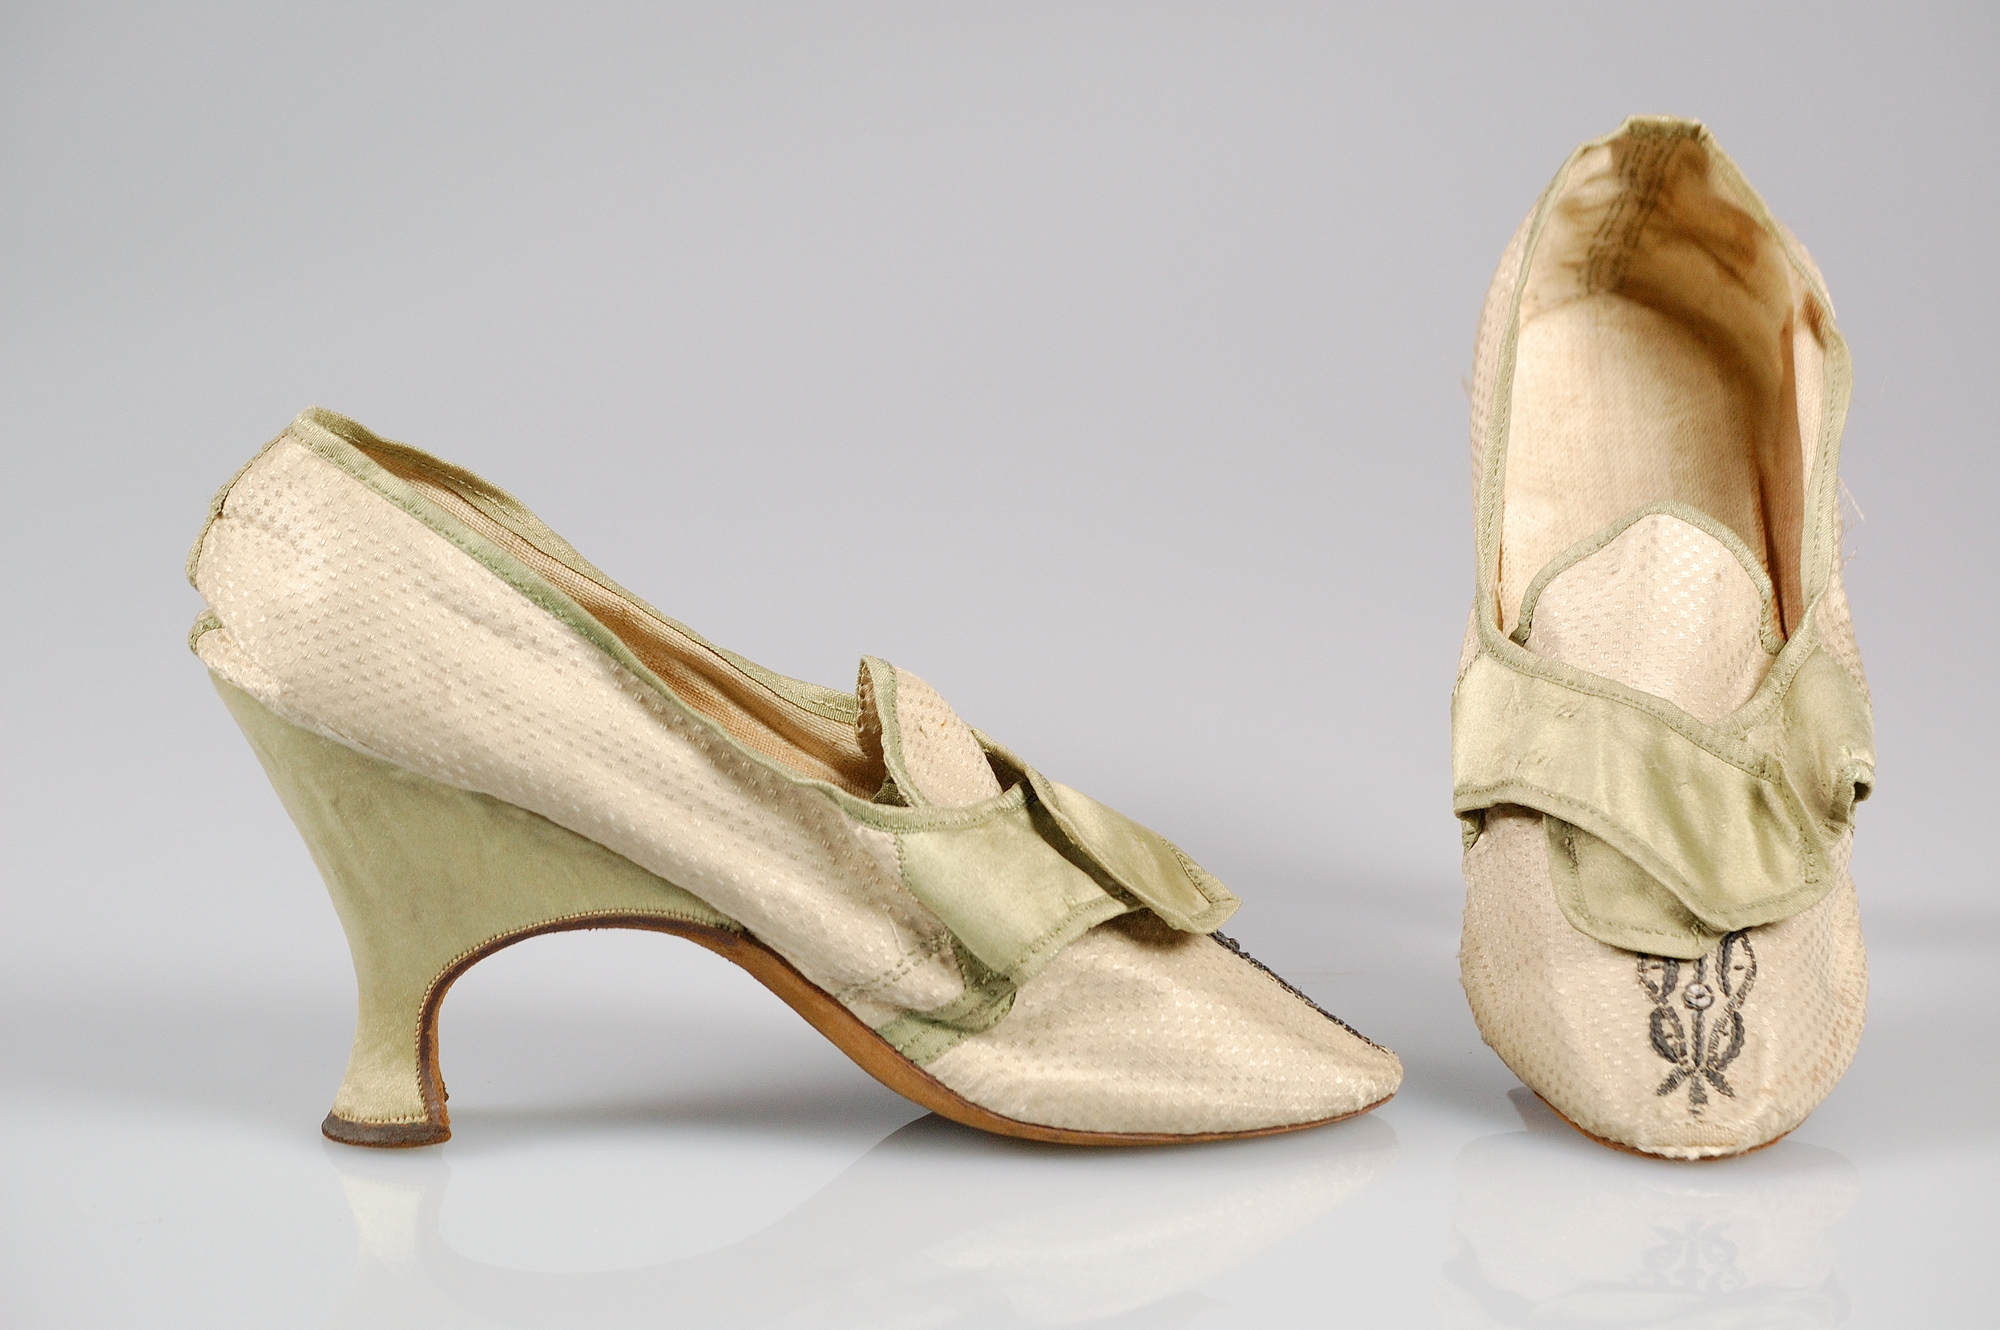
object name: shoe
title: Shoes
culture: european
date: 1770-1789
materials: silk